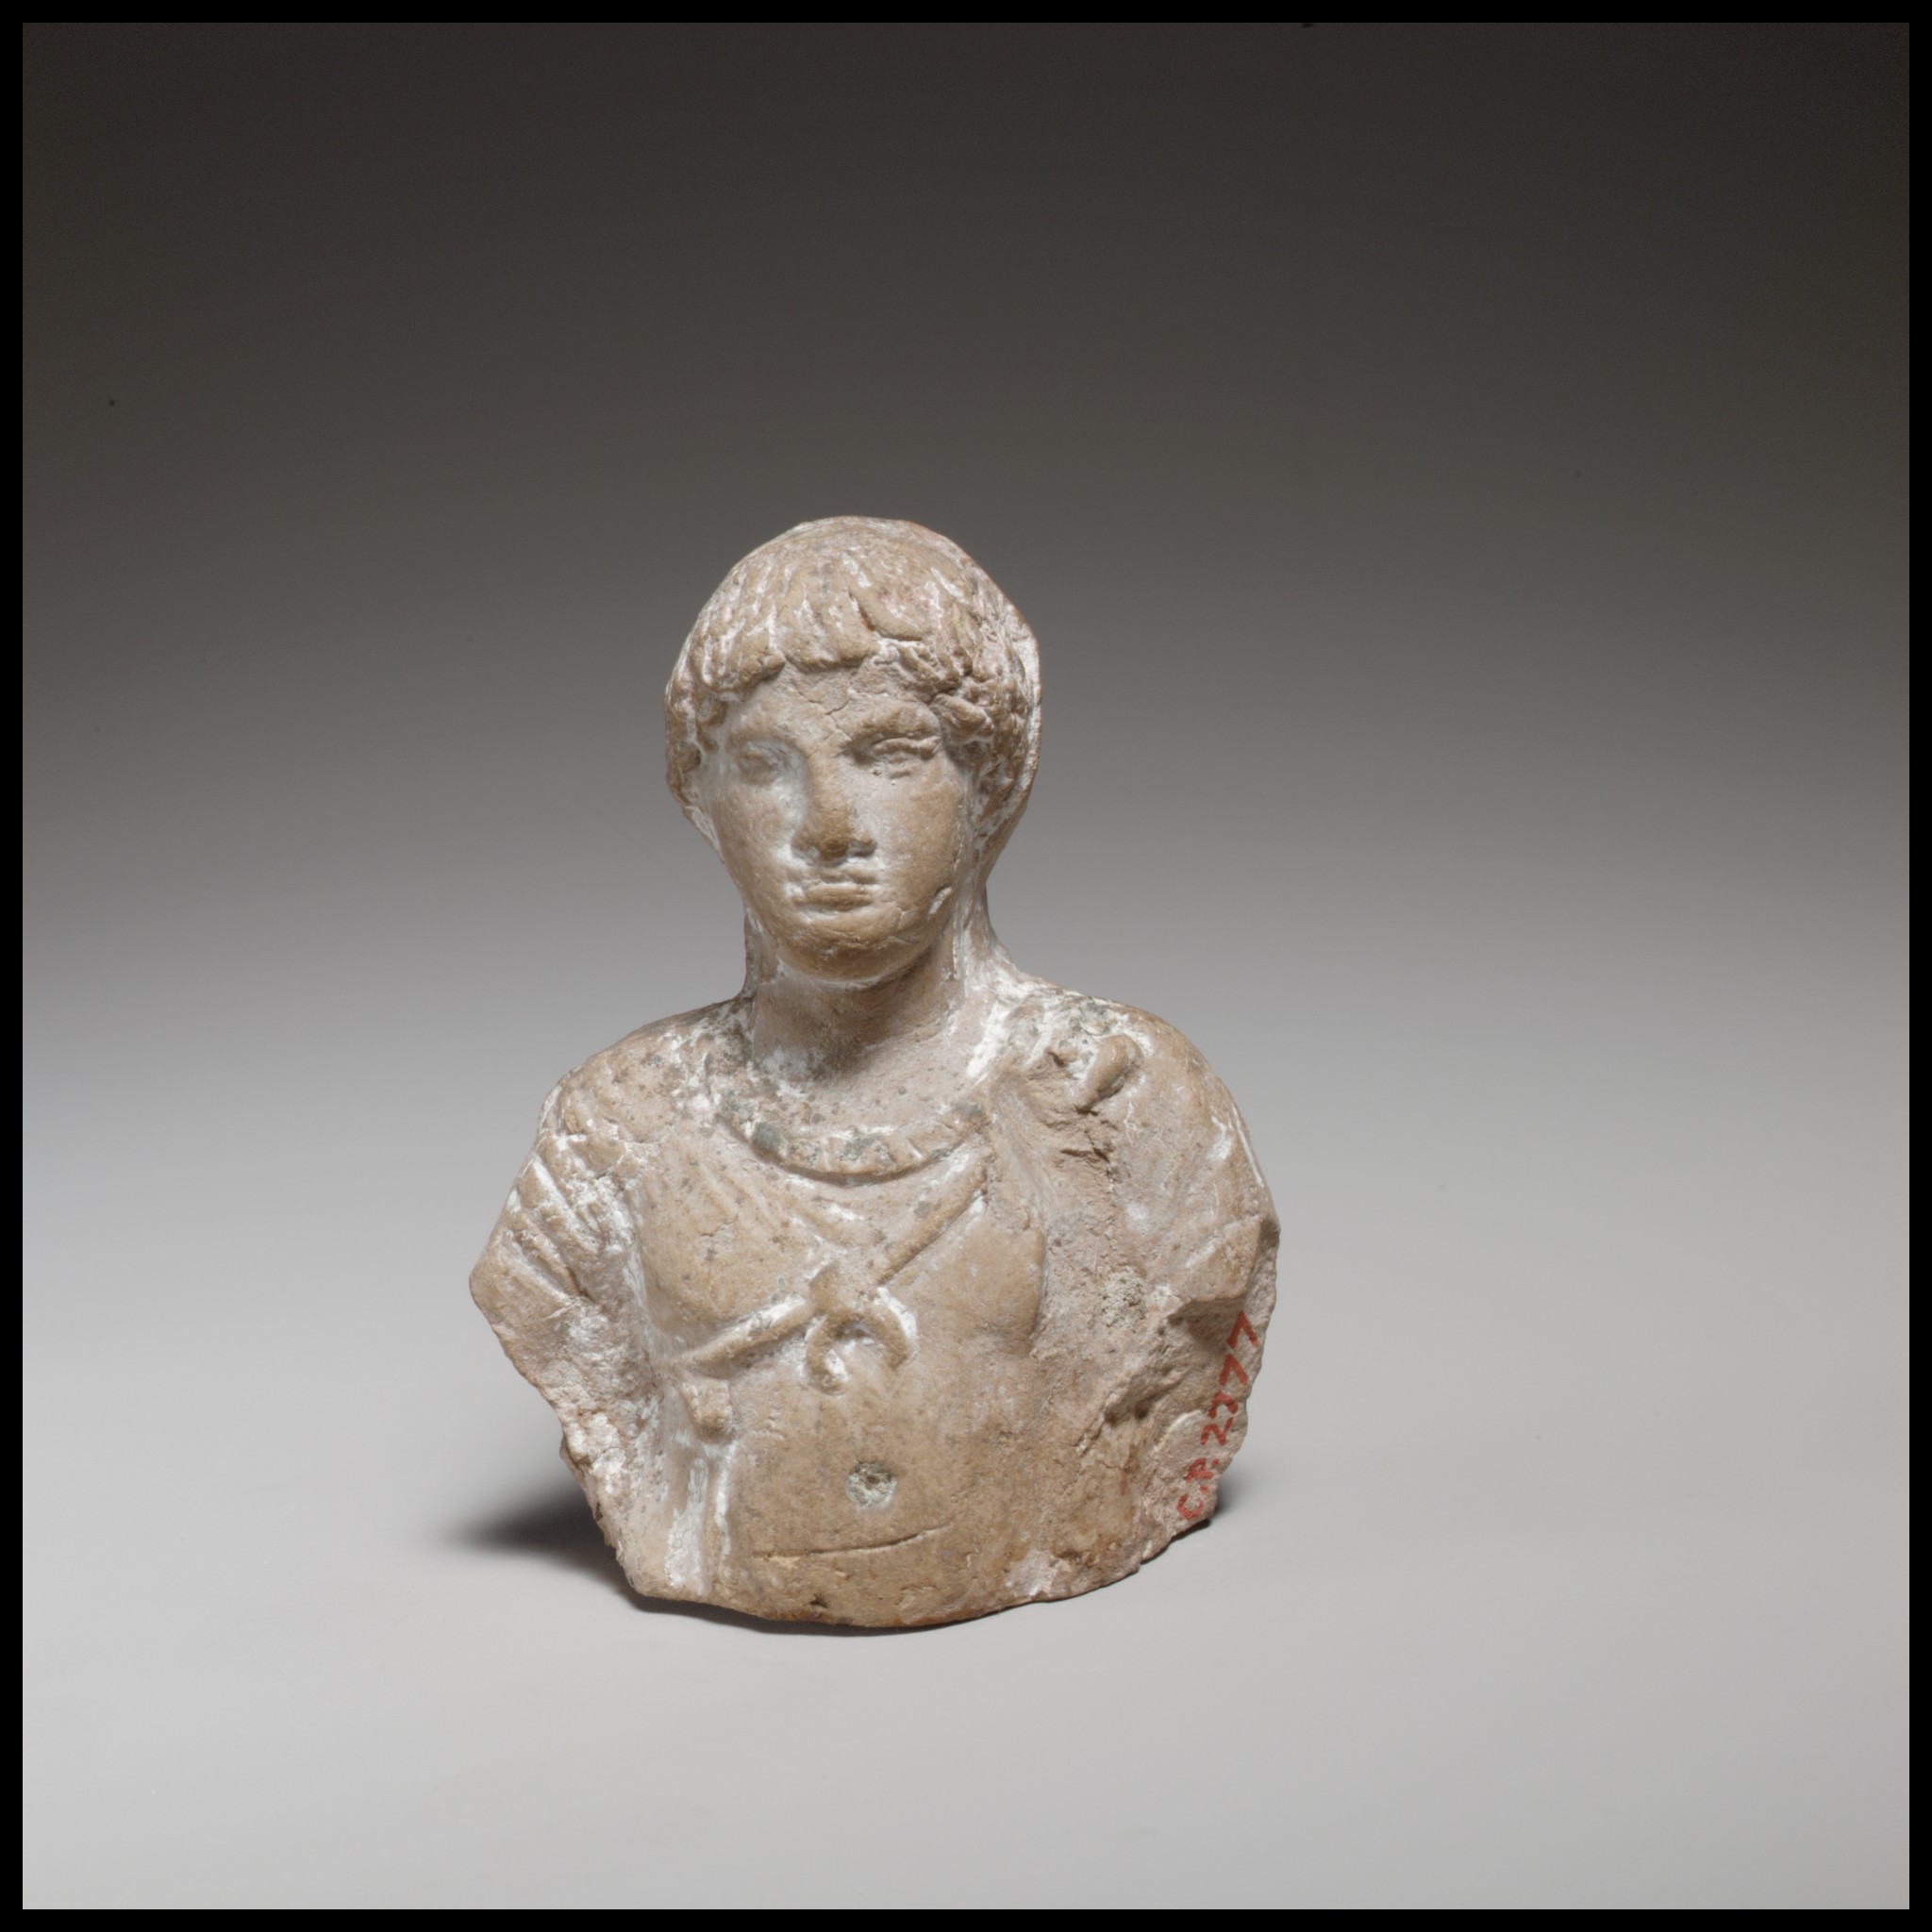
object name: statuette of a votary, male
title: Youth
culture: cypriot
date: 400-301 BCE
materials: terracotta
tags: men